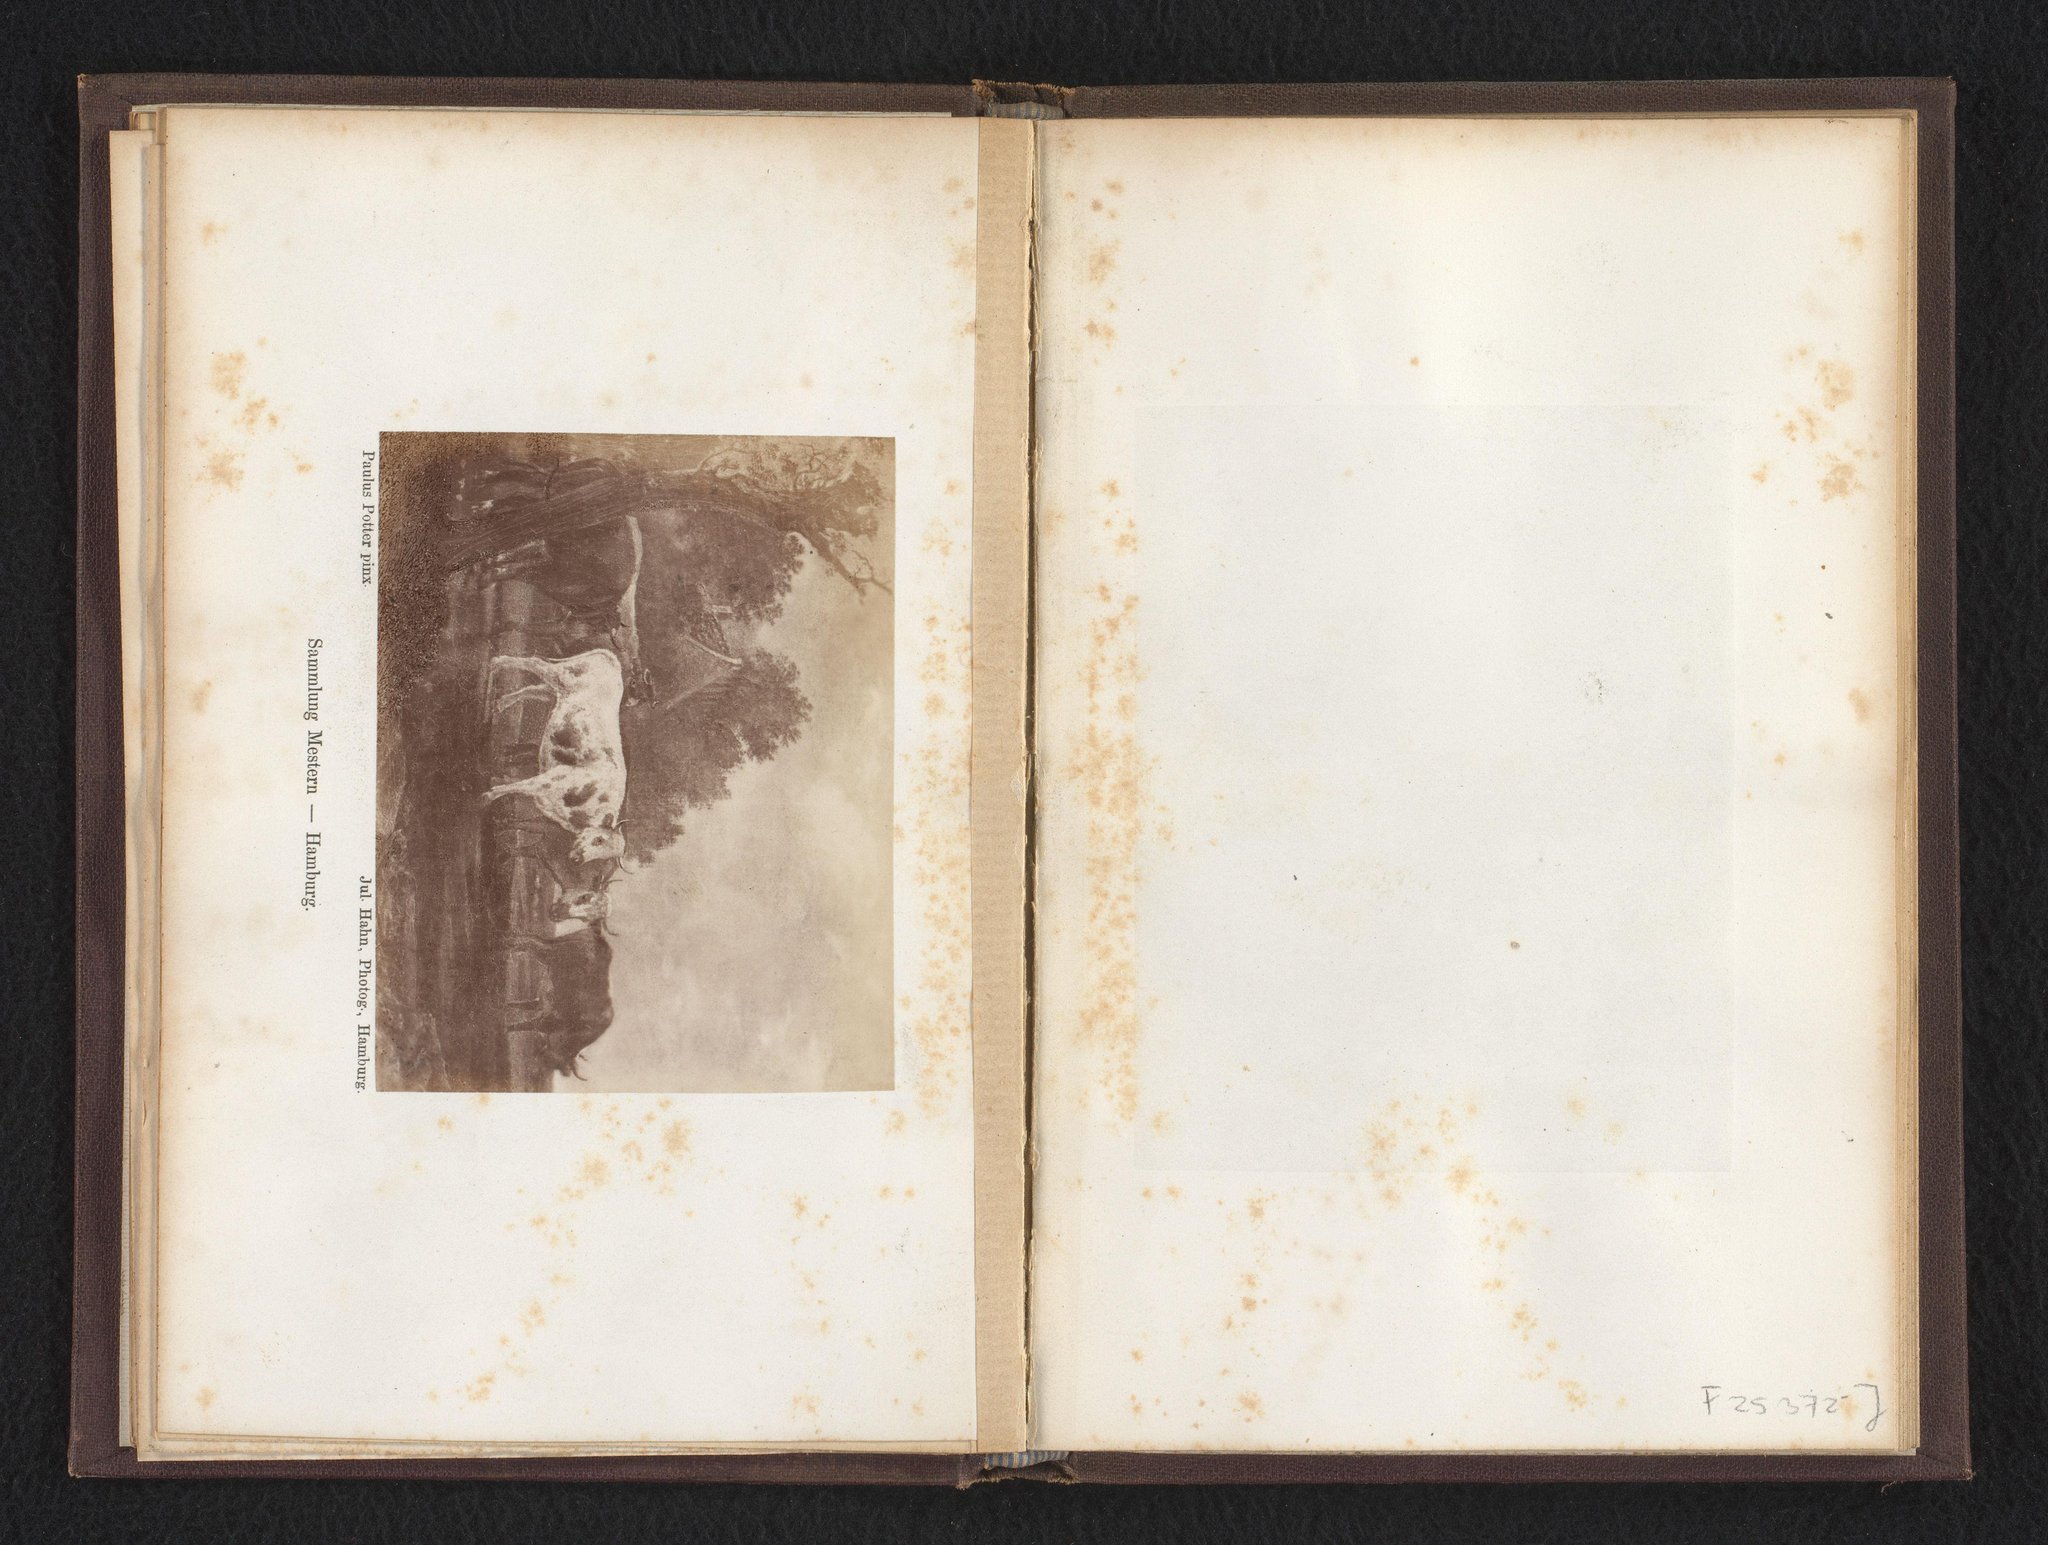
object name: page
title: Fotoreproductie van een schilderij van koeien door Paulus Potter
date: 1864-1874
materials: paper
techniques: albumen print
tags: cow, picture, painting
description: Foto op tweede ongenummerde pagina voor pagina 15.